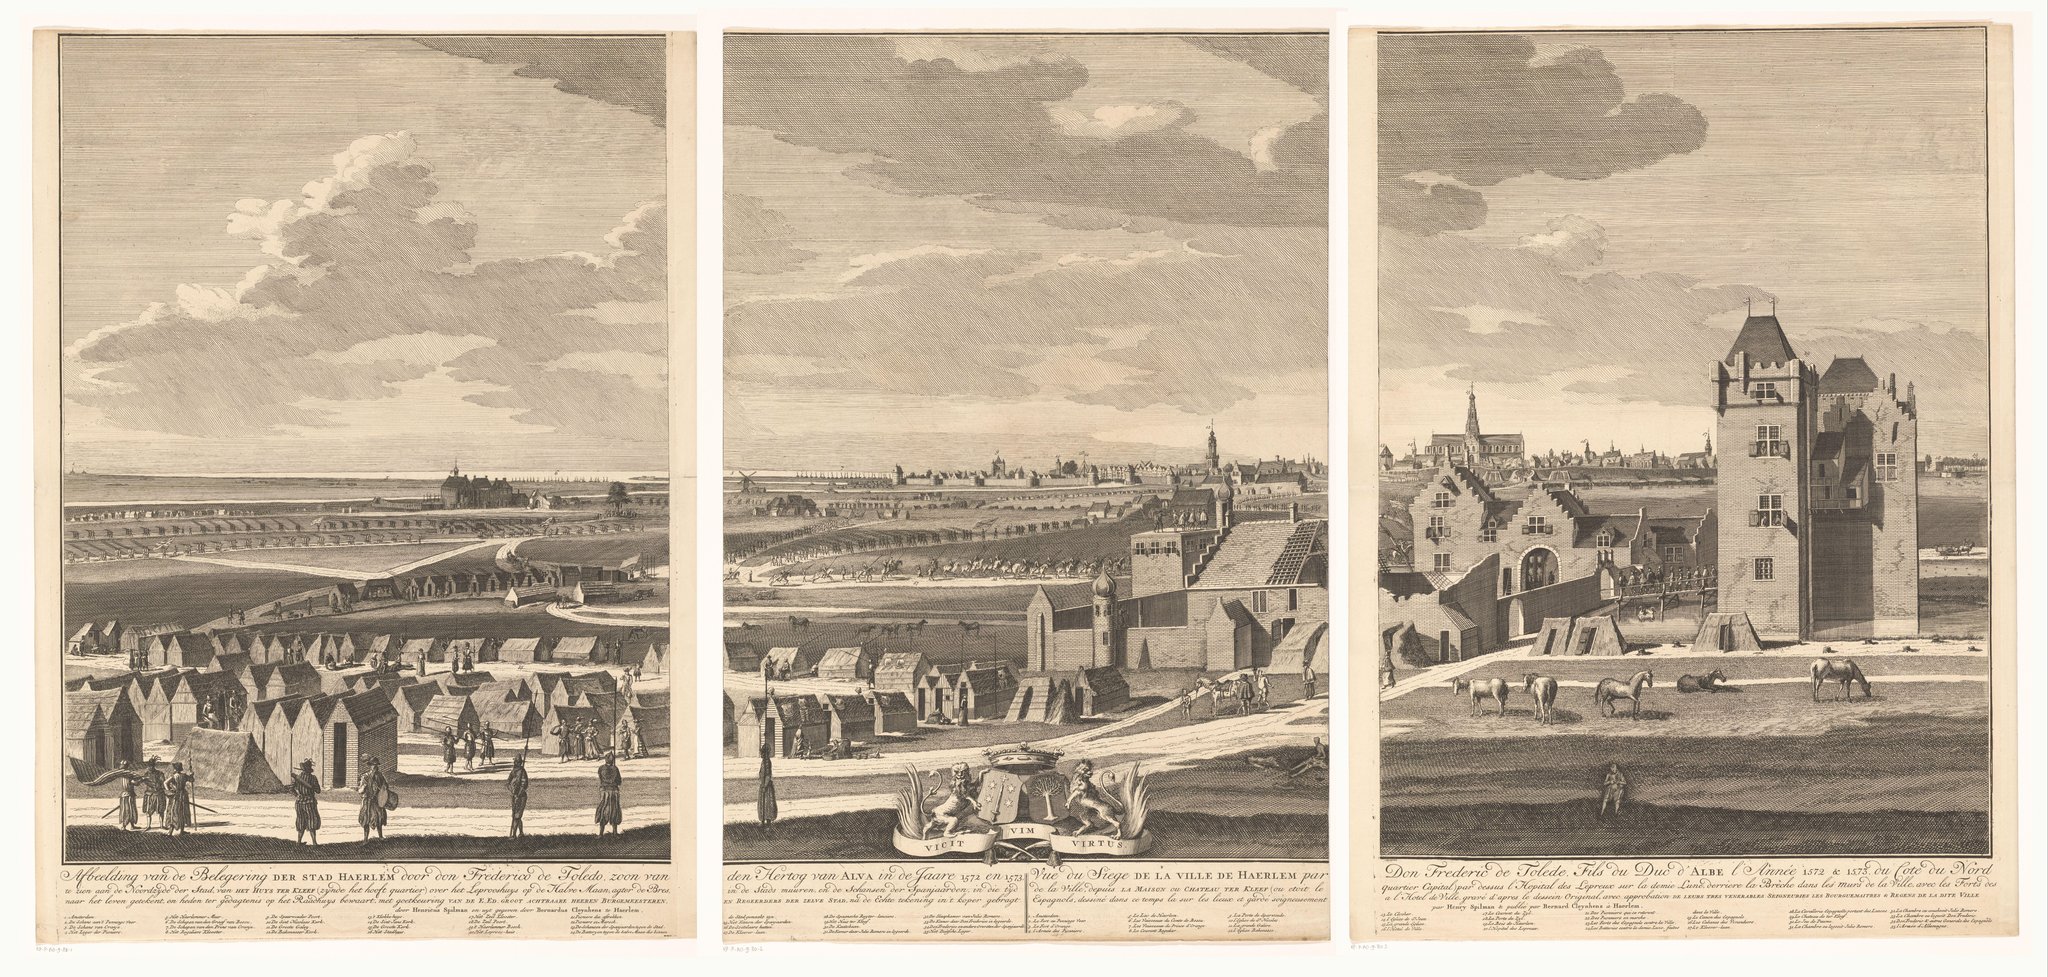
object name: print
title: Afbeelding van de Belegering der stad Haerlem door don Frederico de Toledo, zoon van den Hertog van Alva in de jaare 1572 en 1573, te zien aan de noordzyde der stad, van het Huys ter Kleef (zynde het hooft quartier) over het Leprooshuys op de Halve Maan, agter de Bres, in de stads muuren, en de schansen der Spanjaarden, in die tijd naar het leven getekent (...) / Vue du Siege de la ville de Haerlem par Don Frederic de Tolede, fils du Duc d'Albe l'année 1572 & 1573 (...)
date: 1742-1779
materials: paper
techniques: etching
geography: haarlem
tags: siege, position war, haarlem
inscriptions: check stamp: ‘Archief Ministerie van Oorlog Afdeeling Genie’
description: Belegering van de stad Haarlem in de jaren 1572-1573 door de Spanjaarden onder Fadrique Alvarez de Toledo (Don Frederik), de zoon van de hertog van Alva. Grote voorstelling met een gezicht op de stad vanuit het noorden, in prent naar een eigentijdse tekening in drie bladen. Onder in het midden het wapen van Haarlem. Rechts het Huis ter Kleef, in de verte de Sint Bavo. Onder de voorstelling de titels en de legenda's 1-35 in het Nederlands en Frans.